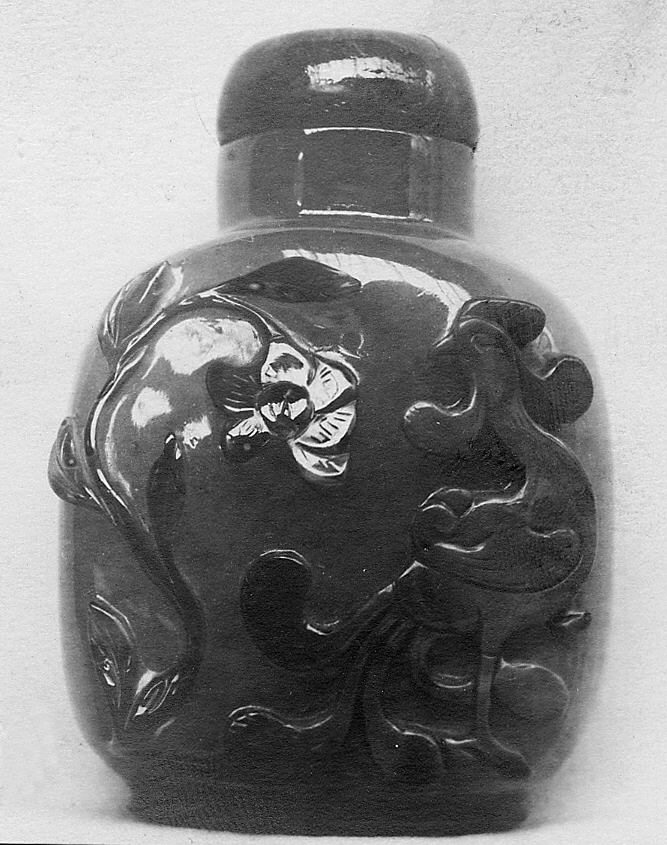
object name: snuff bottle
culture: chinese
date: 1736-1795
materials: gemstone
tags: birds